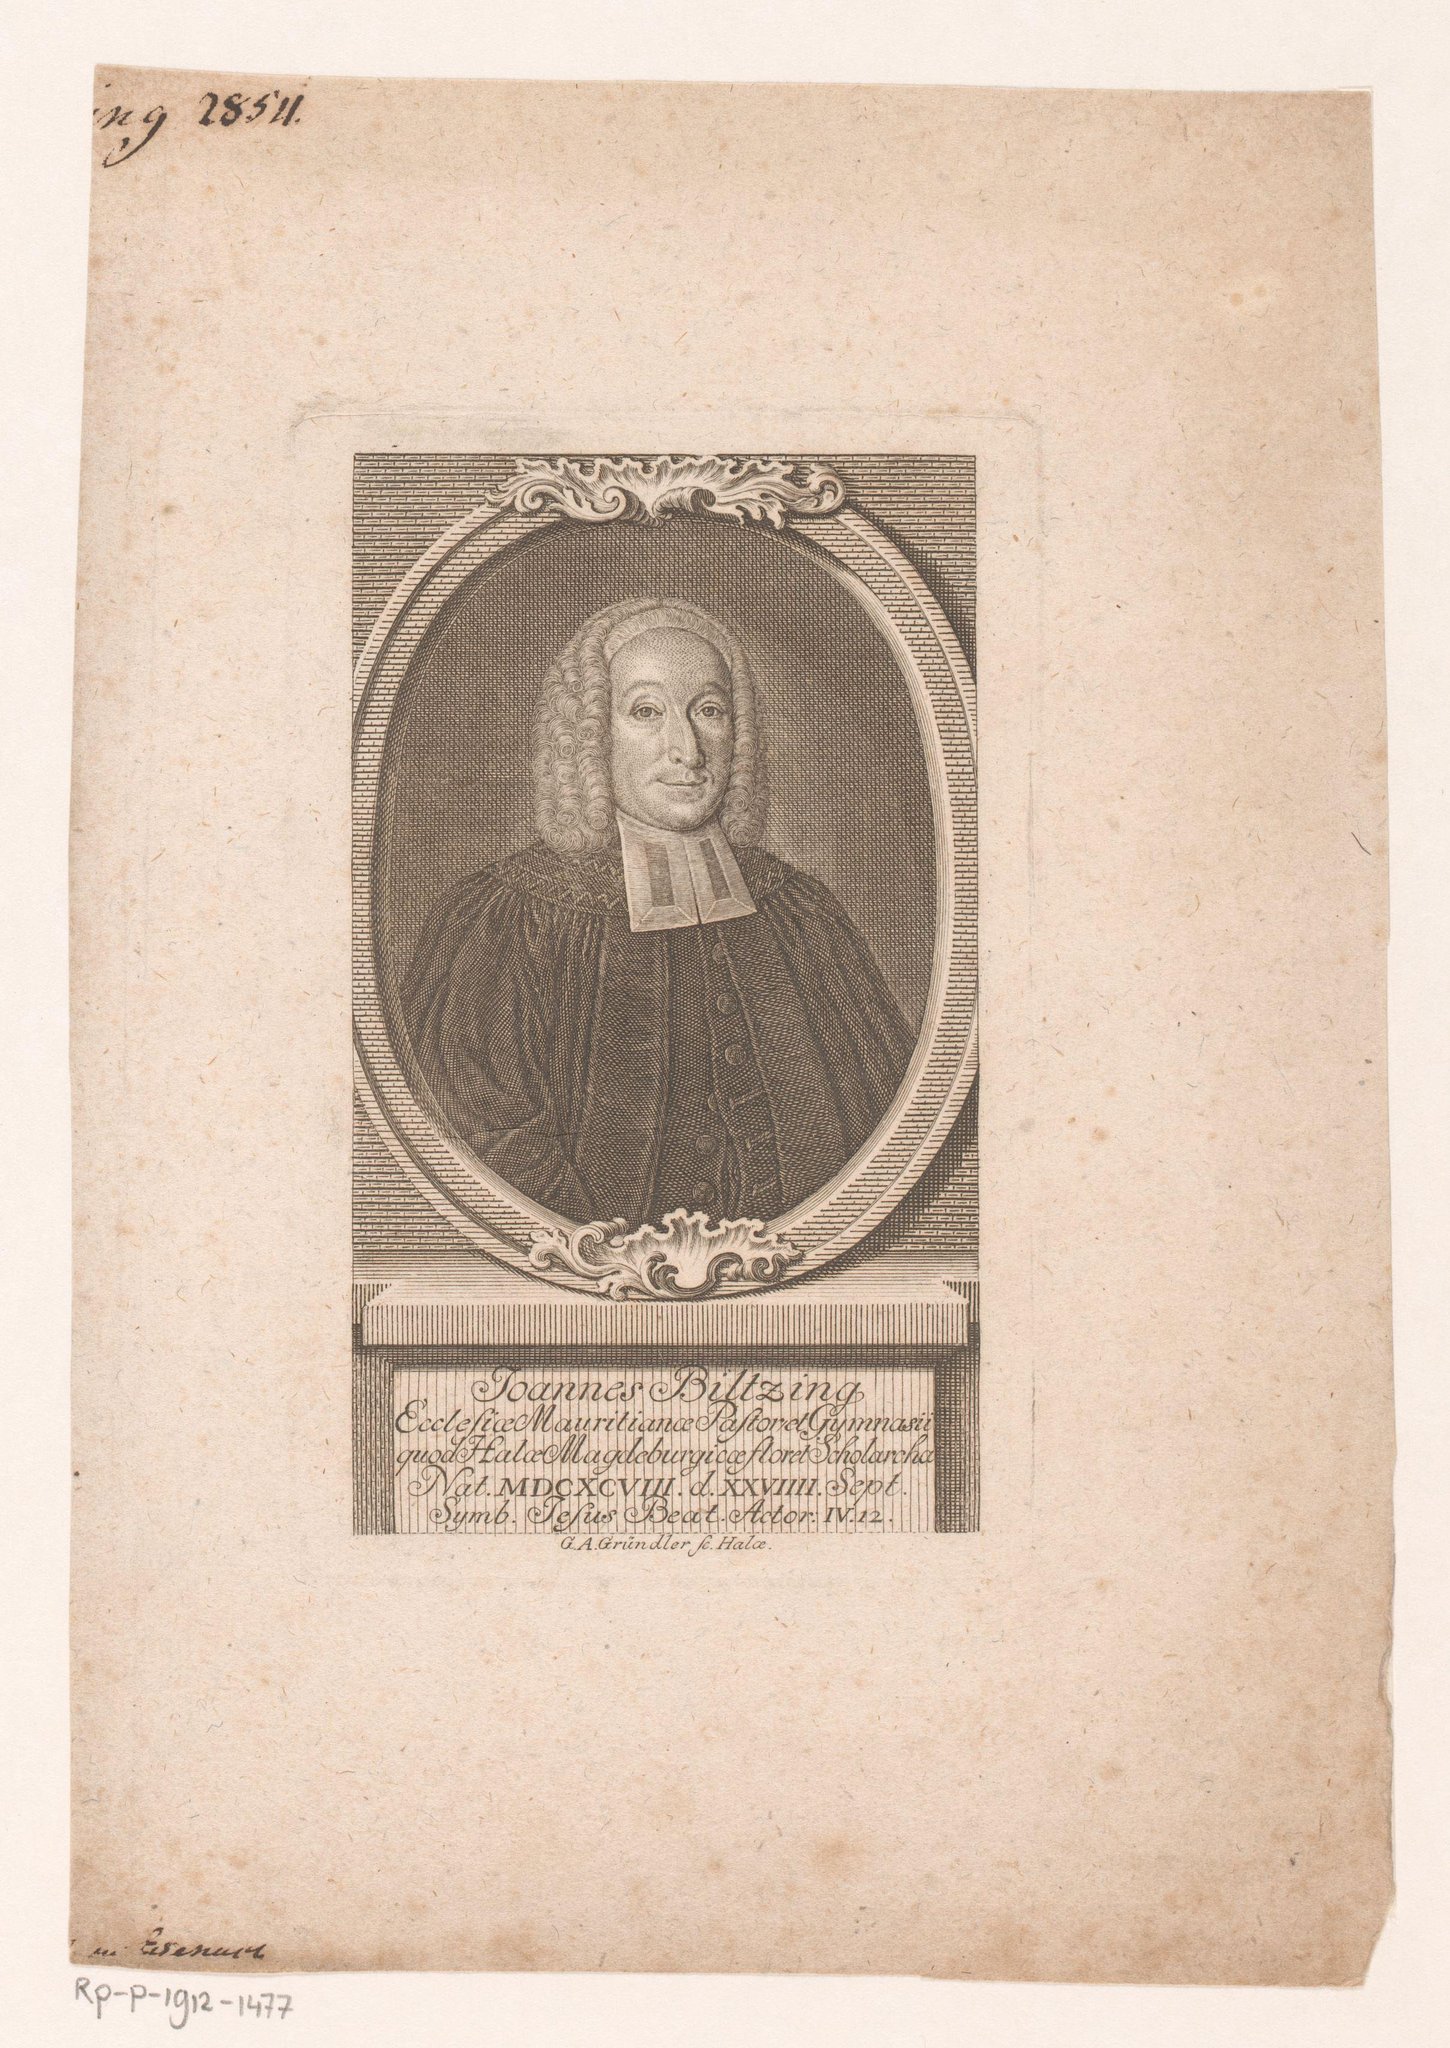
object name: print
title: Portret van Johannes Biltzing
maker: gottfried august gründler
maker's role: painter, print maker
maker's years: 1710-1775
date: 1720-1762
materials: paper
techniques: engraving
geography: halle an der saale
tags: rocaille ornament, theologian, historical persons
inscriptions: collector's mark: Lugt 2228